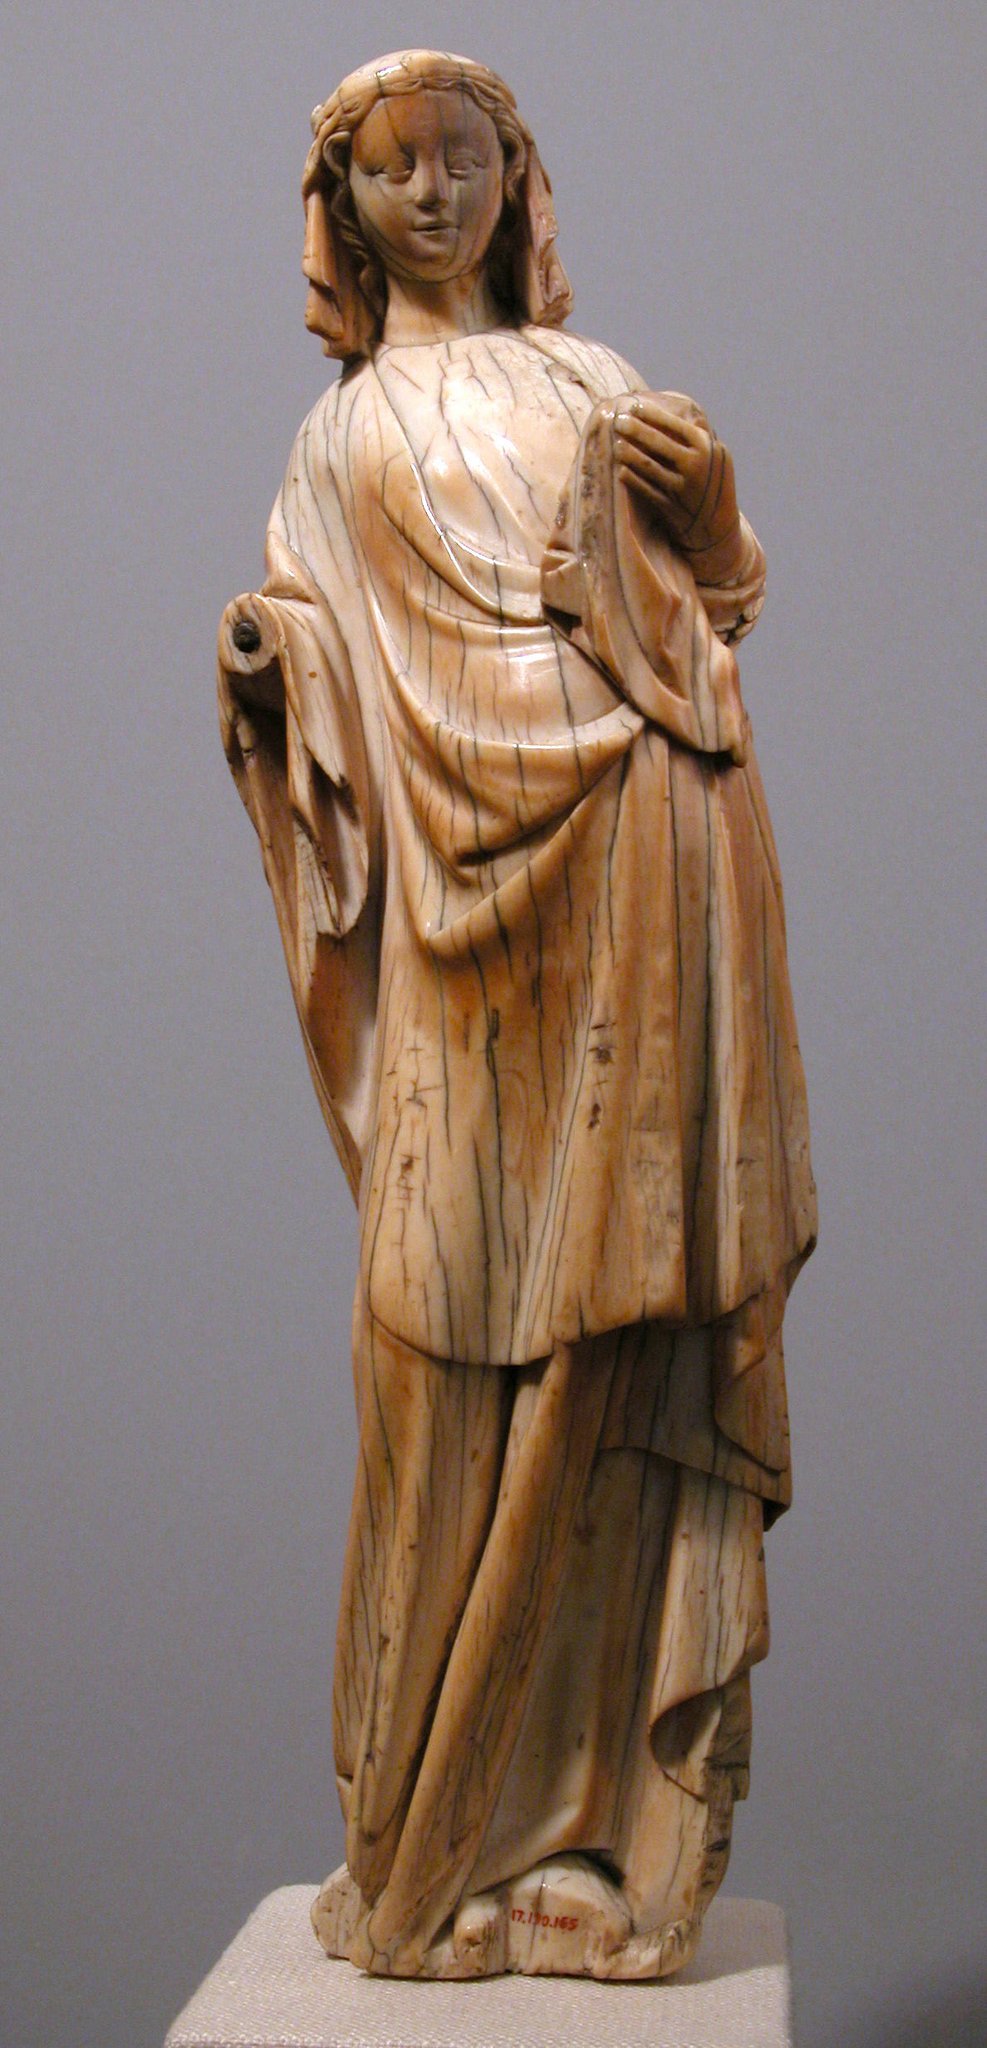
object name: statuette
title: Standing Virgin and Child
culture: french, north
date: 1270-1280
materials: ivory